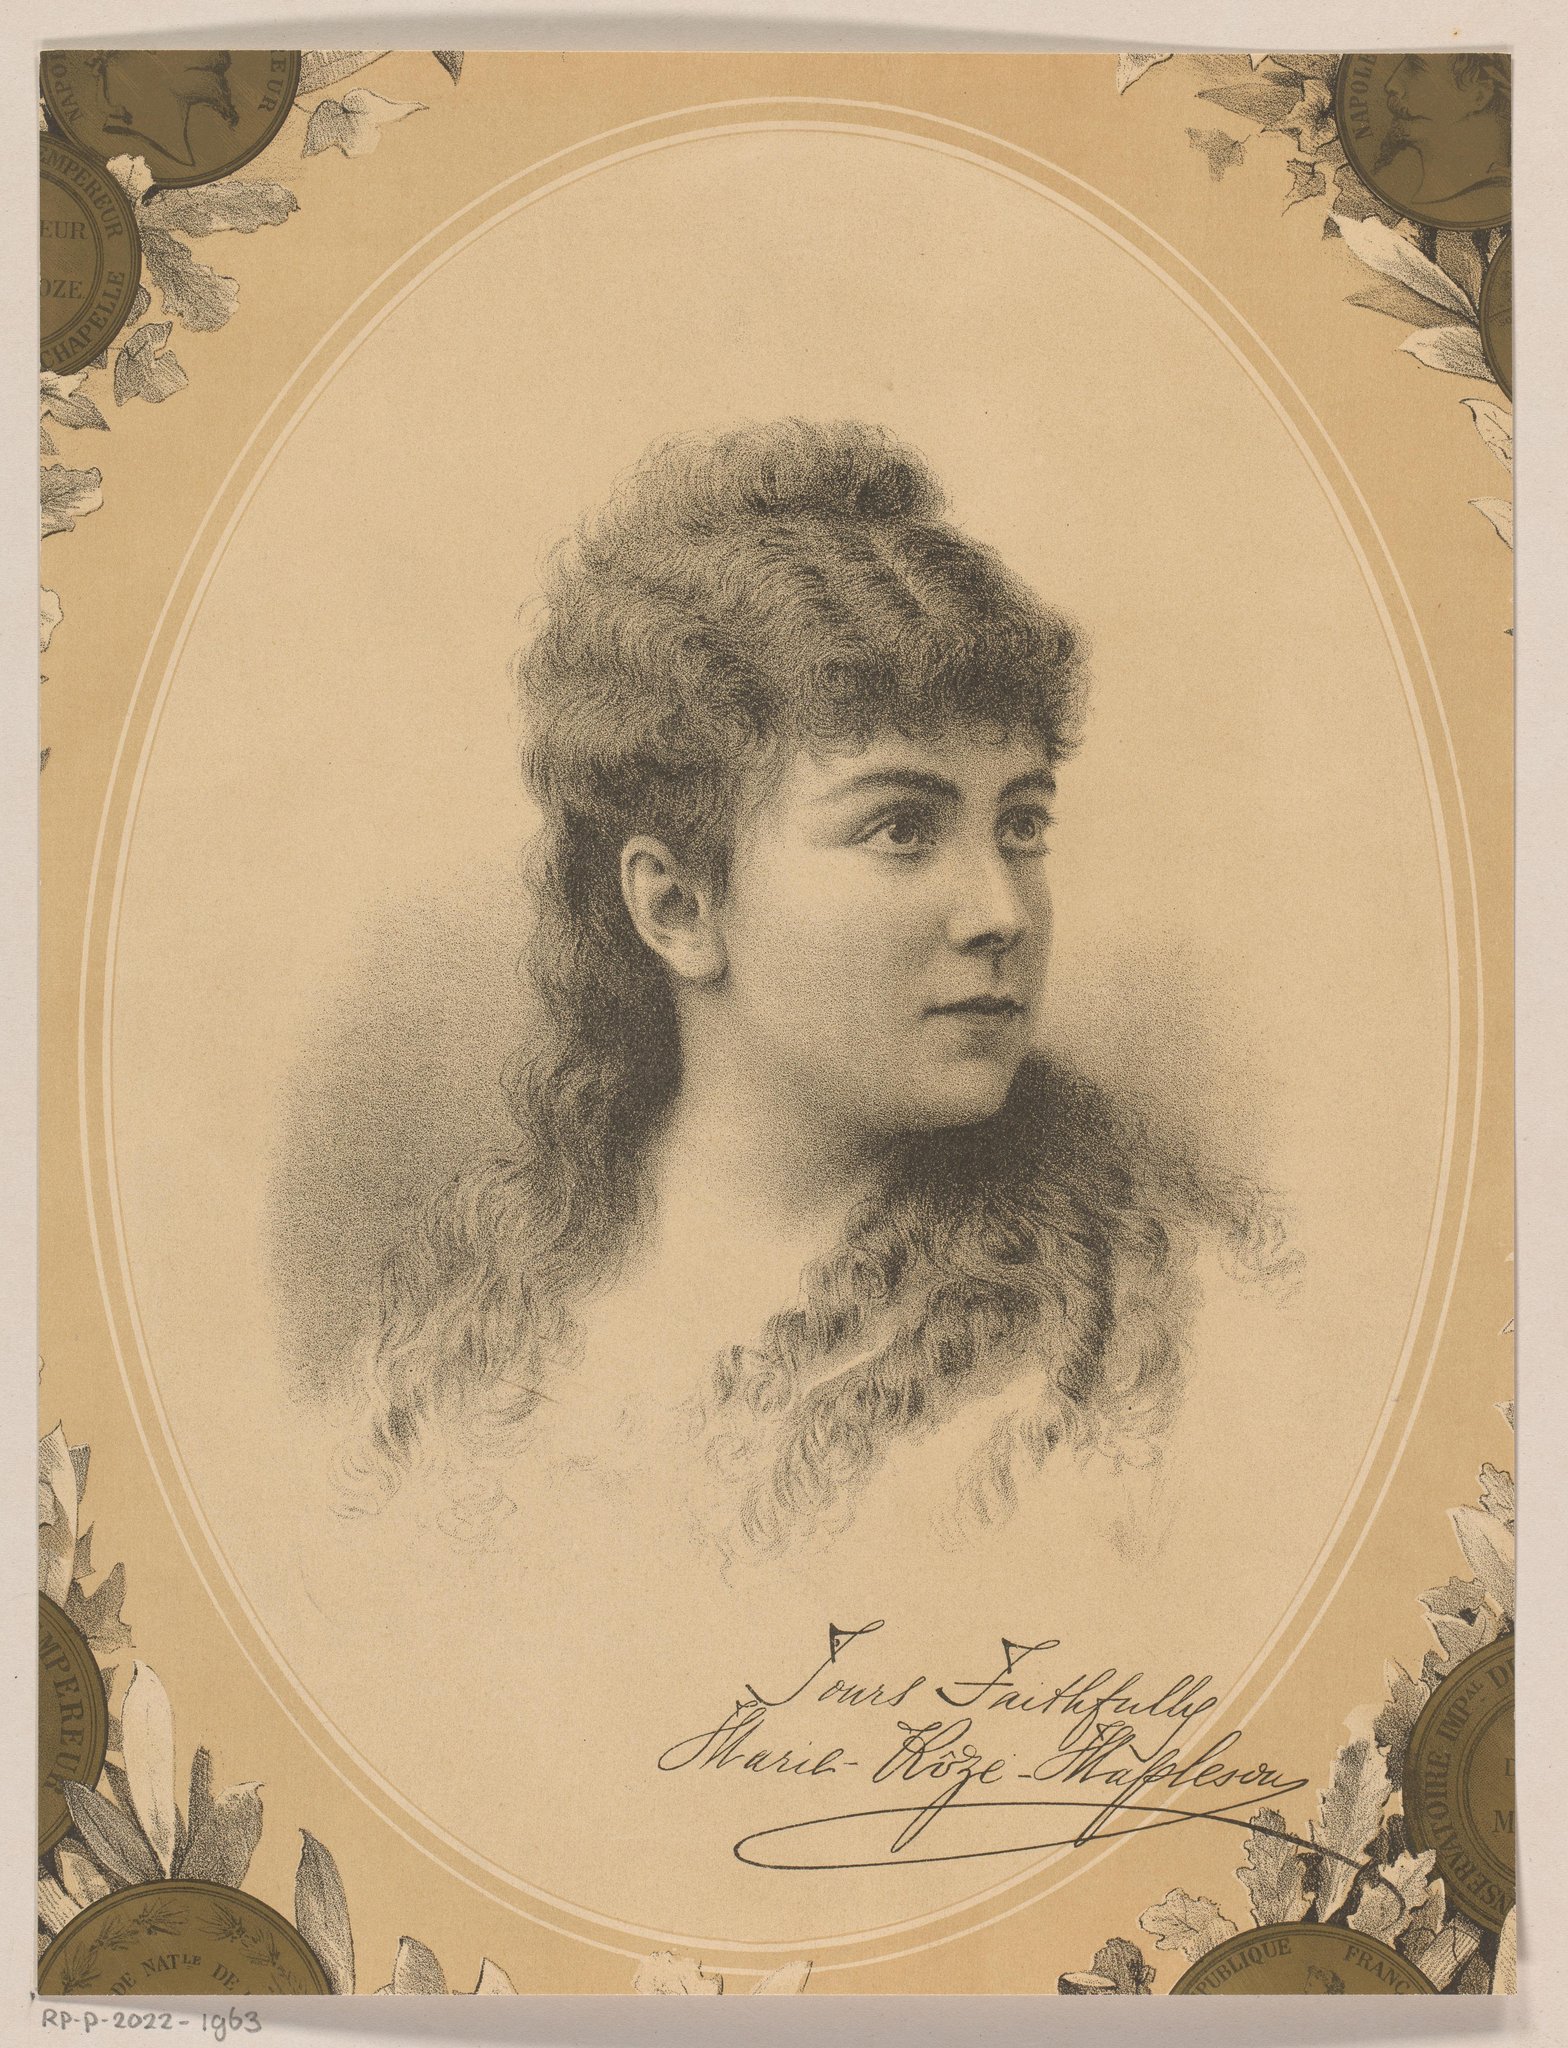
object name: print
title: Portret van Marie Roze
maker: Anonymous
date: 1866-1899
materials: paper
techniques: tone lithography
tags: marie roze, historical persons, portrait of opera-singer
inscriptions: inscription: ‘geschenk van den hr Volmer / Mei : 89’